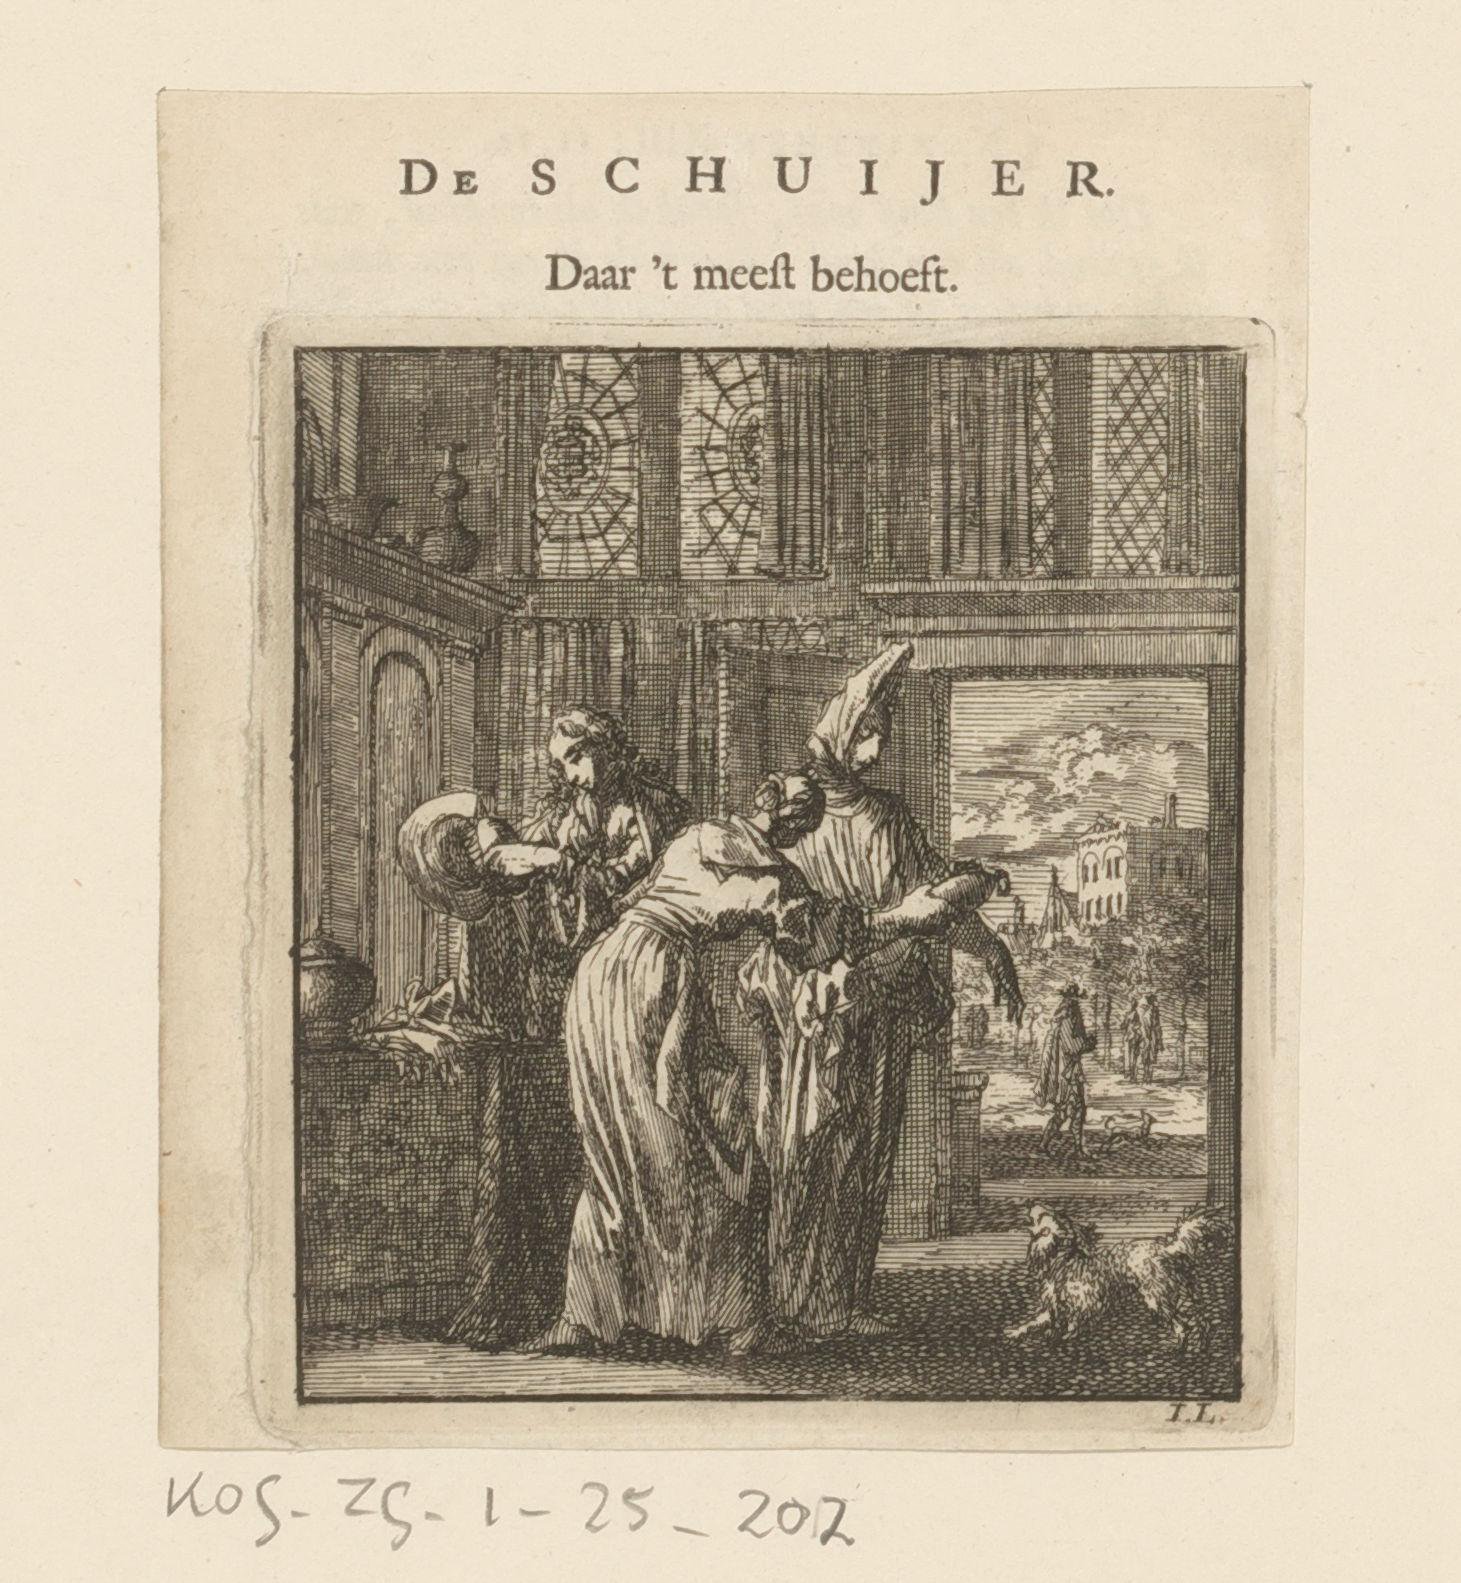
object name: book illustration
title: De Schuijer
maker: jan luyken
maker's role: draughtsman, print maker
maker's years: 1649-1712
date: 1711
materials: paper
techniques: etching, letterpress printing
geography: amsterdam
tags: preparations ~ travelling, dog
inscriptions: stamp, collector's mark: Lugt 1641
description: Prent uit: Luyken, Jan. Het leerzaam huisraad, vertoond in vyftig konstige figuuren, met godlyke spreuken en stichtelyke verzen. Amsterdam: weduwe Pieter Arentsz. II en Cornelis van der Sys, 1711, p. 58.